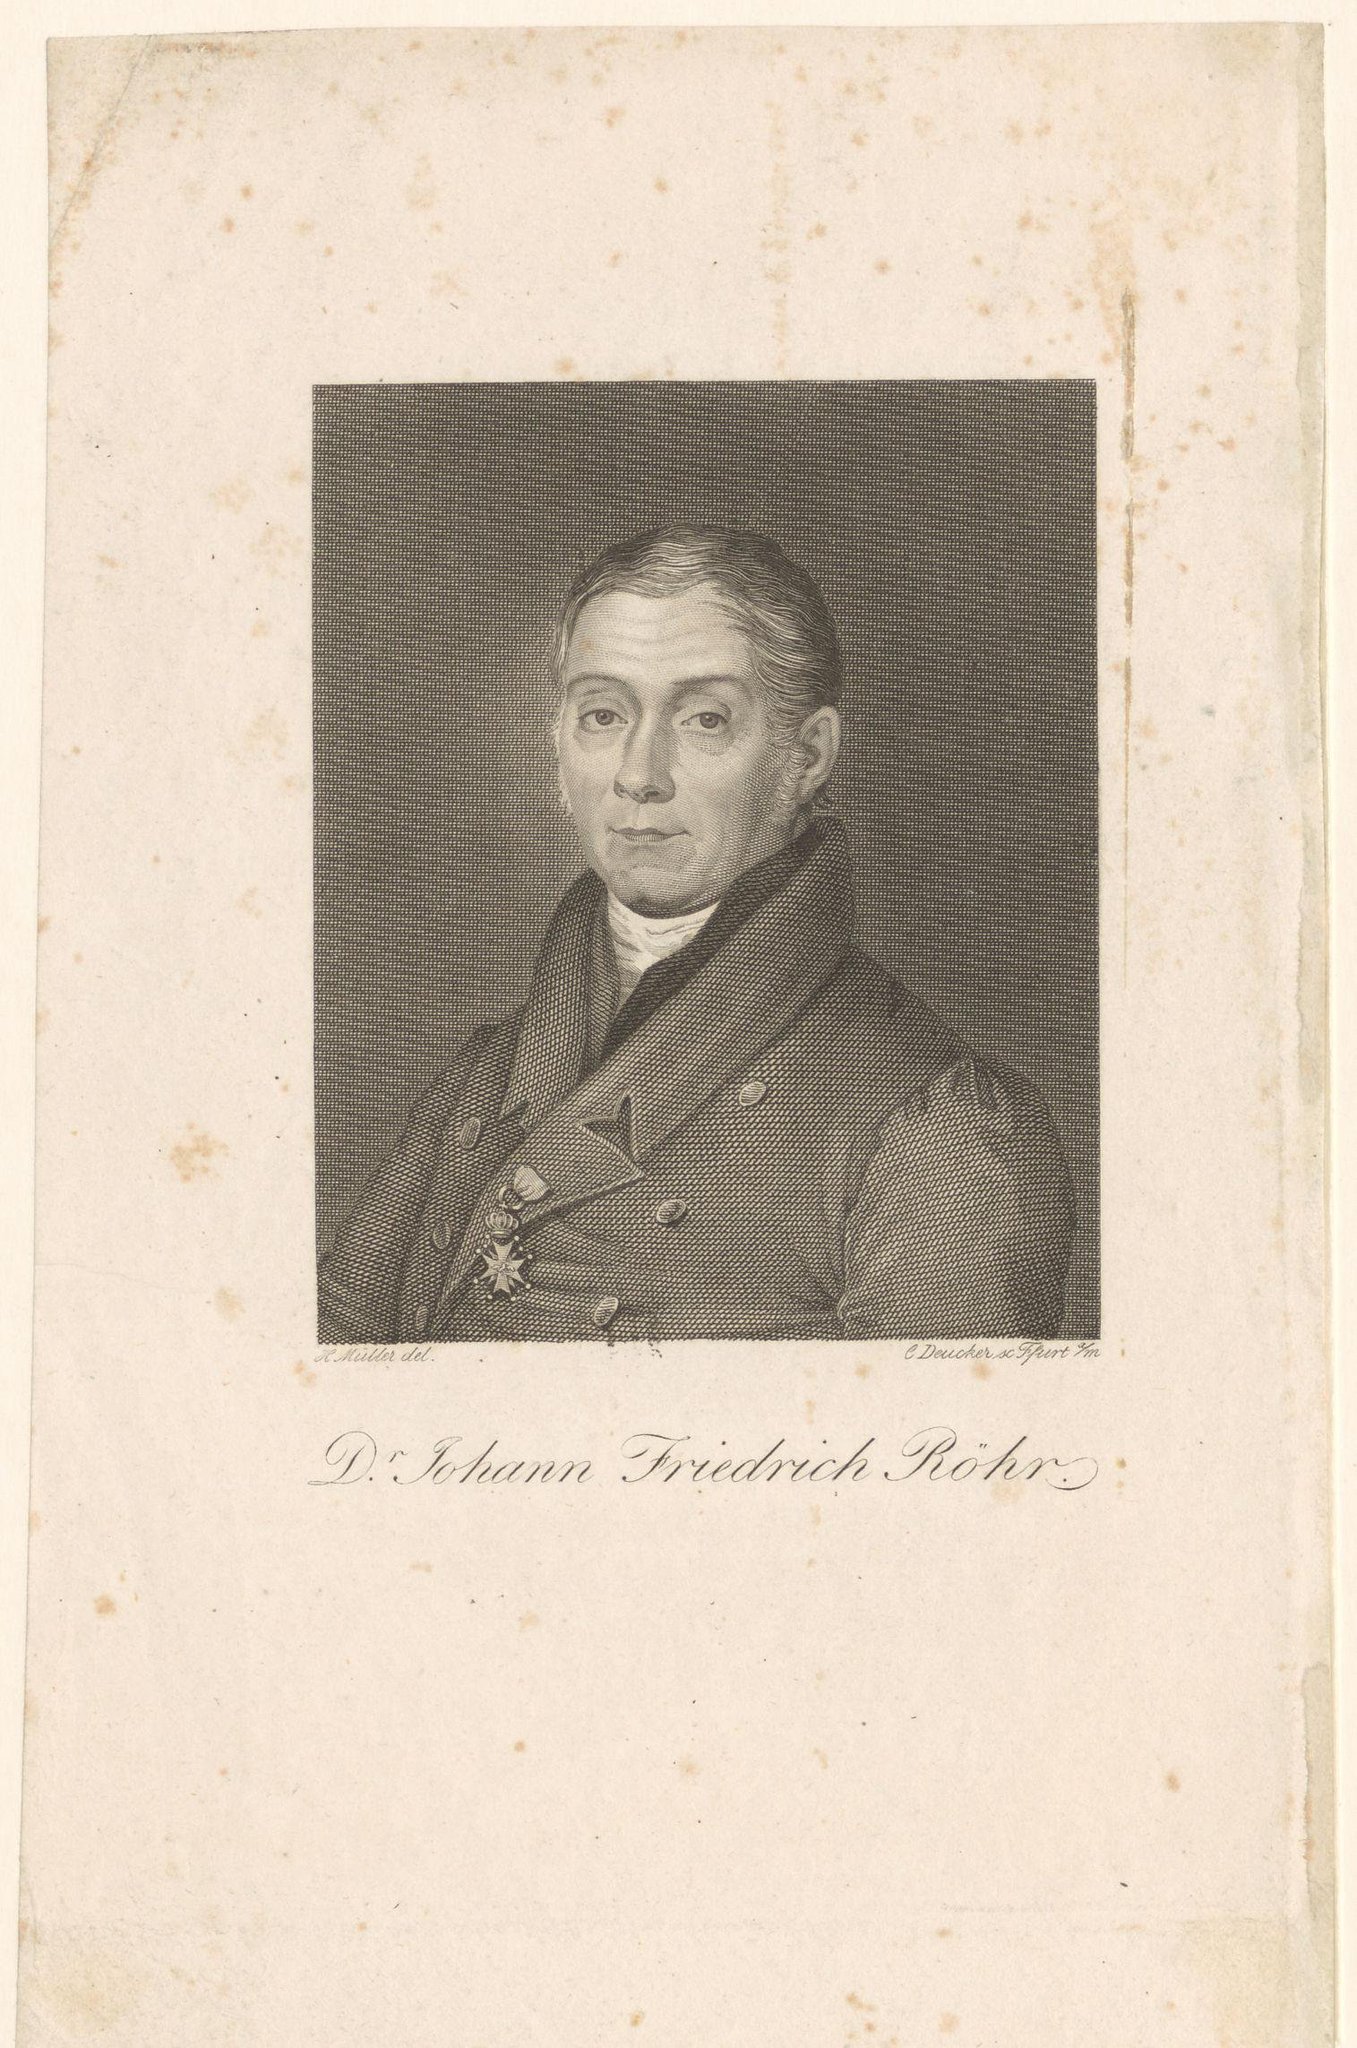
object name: print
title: Portret van Johann Friedrich Röhr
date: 1811-1863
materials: paper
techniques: engraving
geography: frankfurt am main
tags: knighthood order, historical persons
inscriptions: collector's mark: Lugt 2228